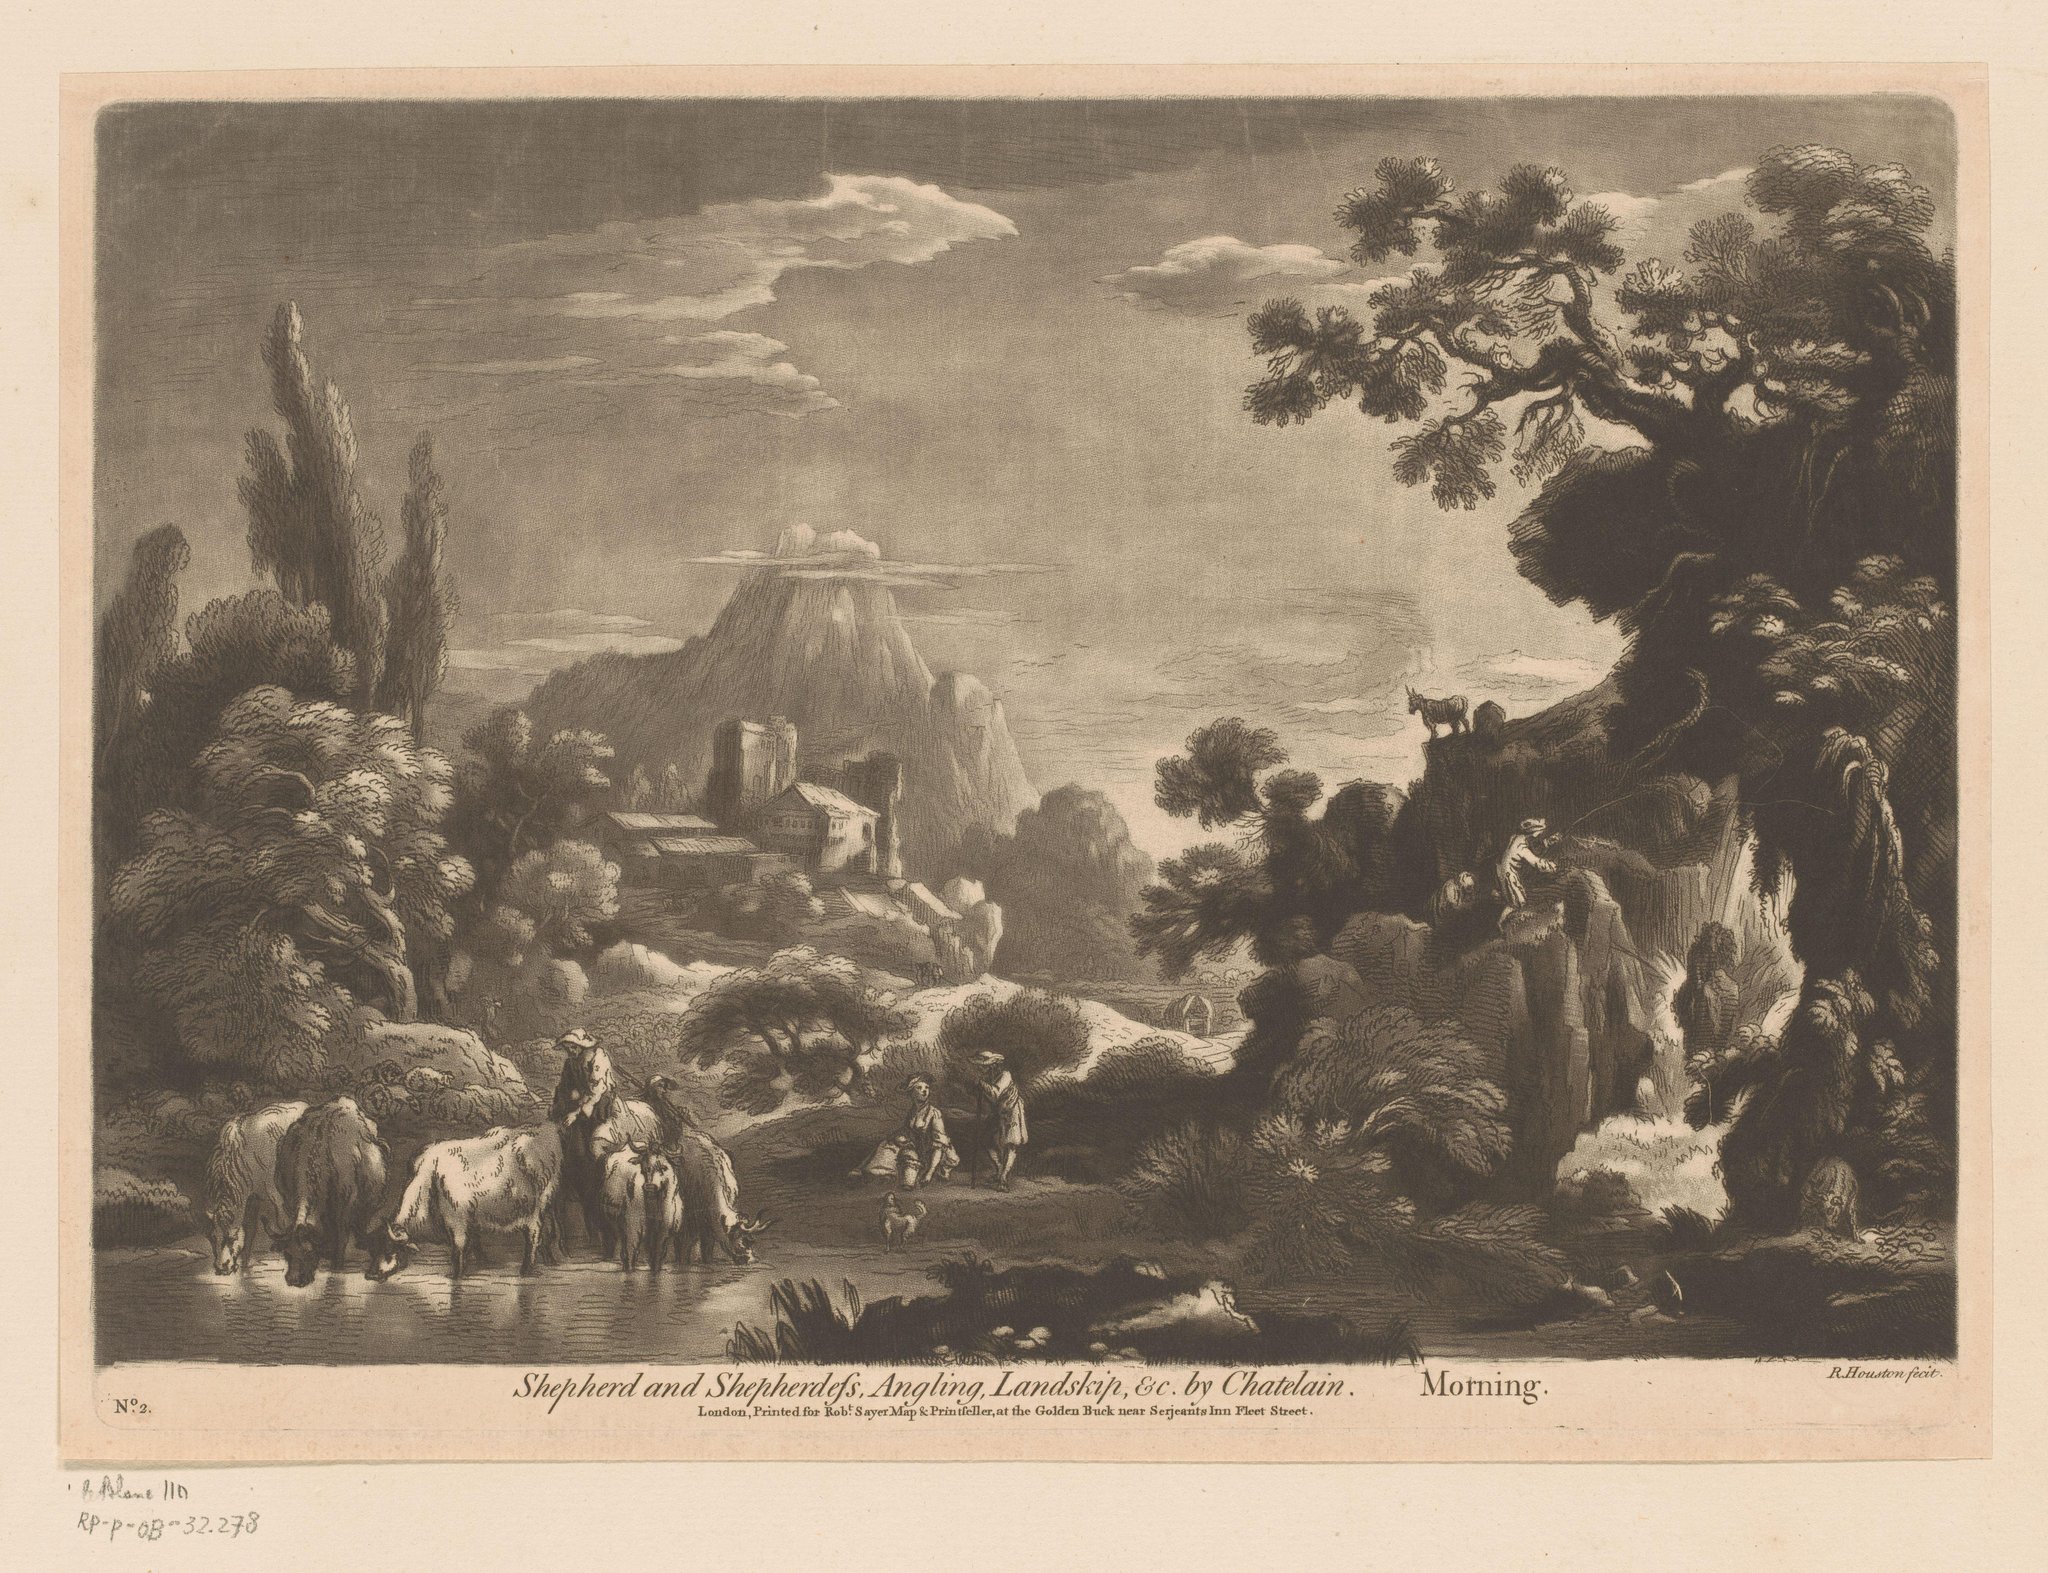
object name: print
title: Shepherd and Shepherdess, Angling, Landskip, &c. by Chatelain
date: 1745-1794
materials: paper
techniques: etching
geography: london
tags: waterfall, low hill country (+ landscape with figures, staffage), fisherman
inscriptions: collector's mark: Lugt 240